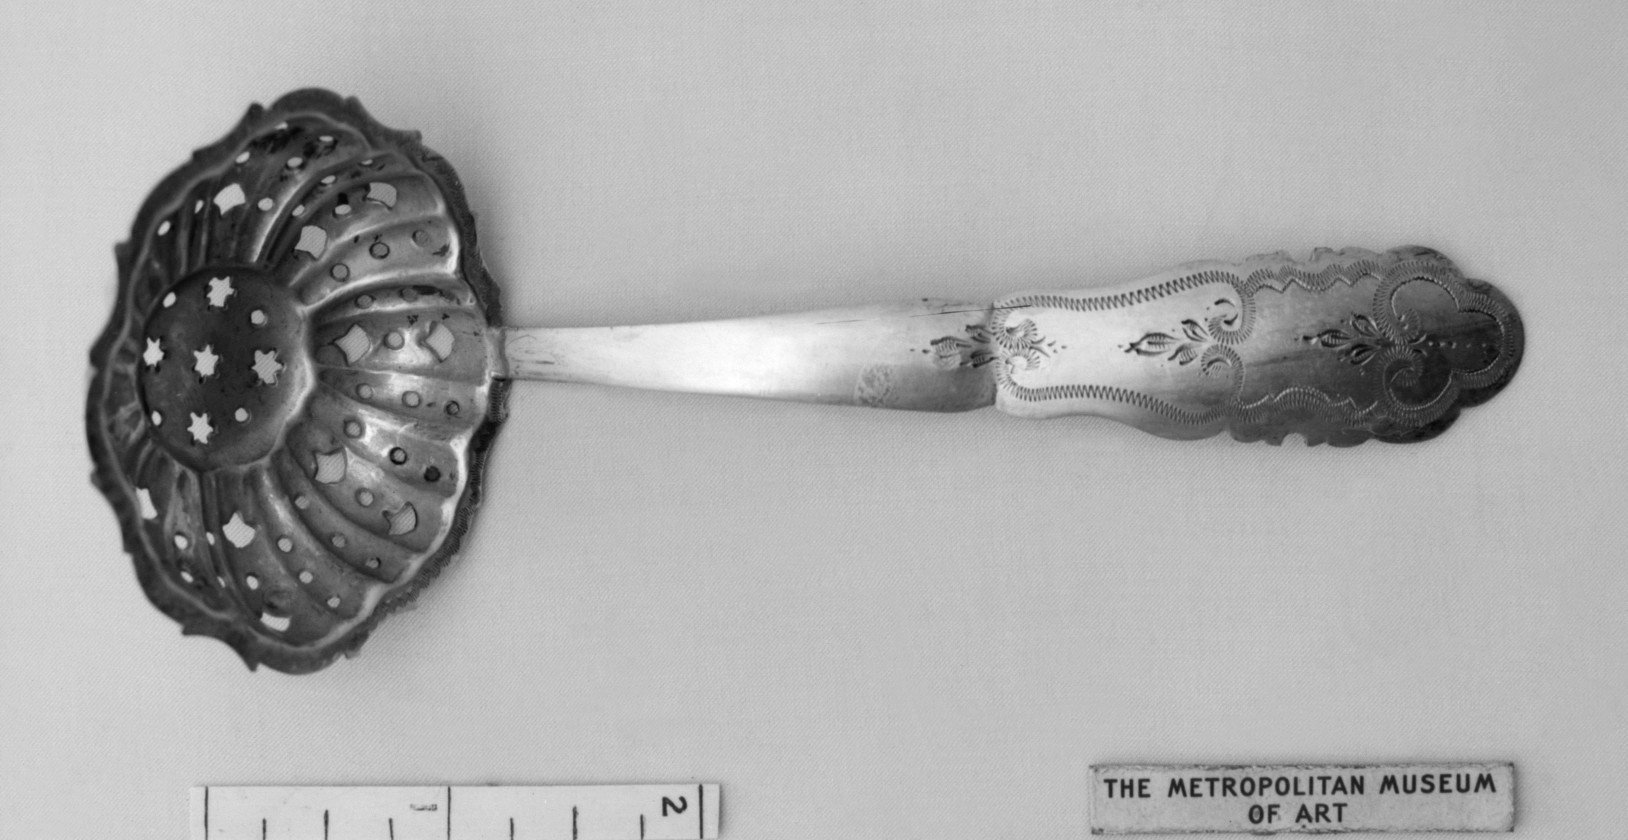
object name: sugar sifter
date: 1867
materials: silver